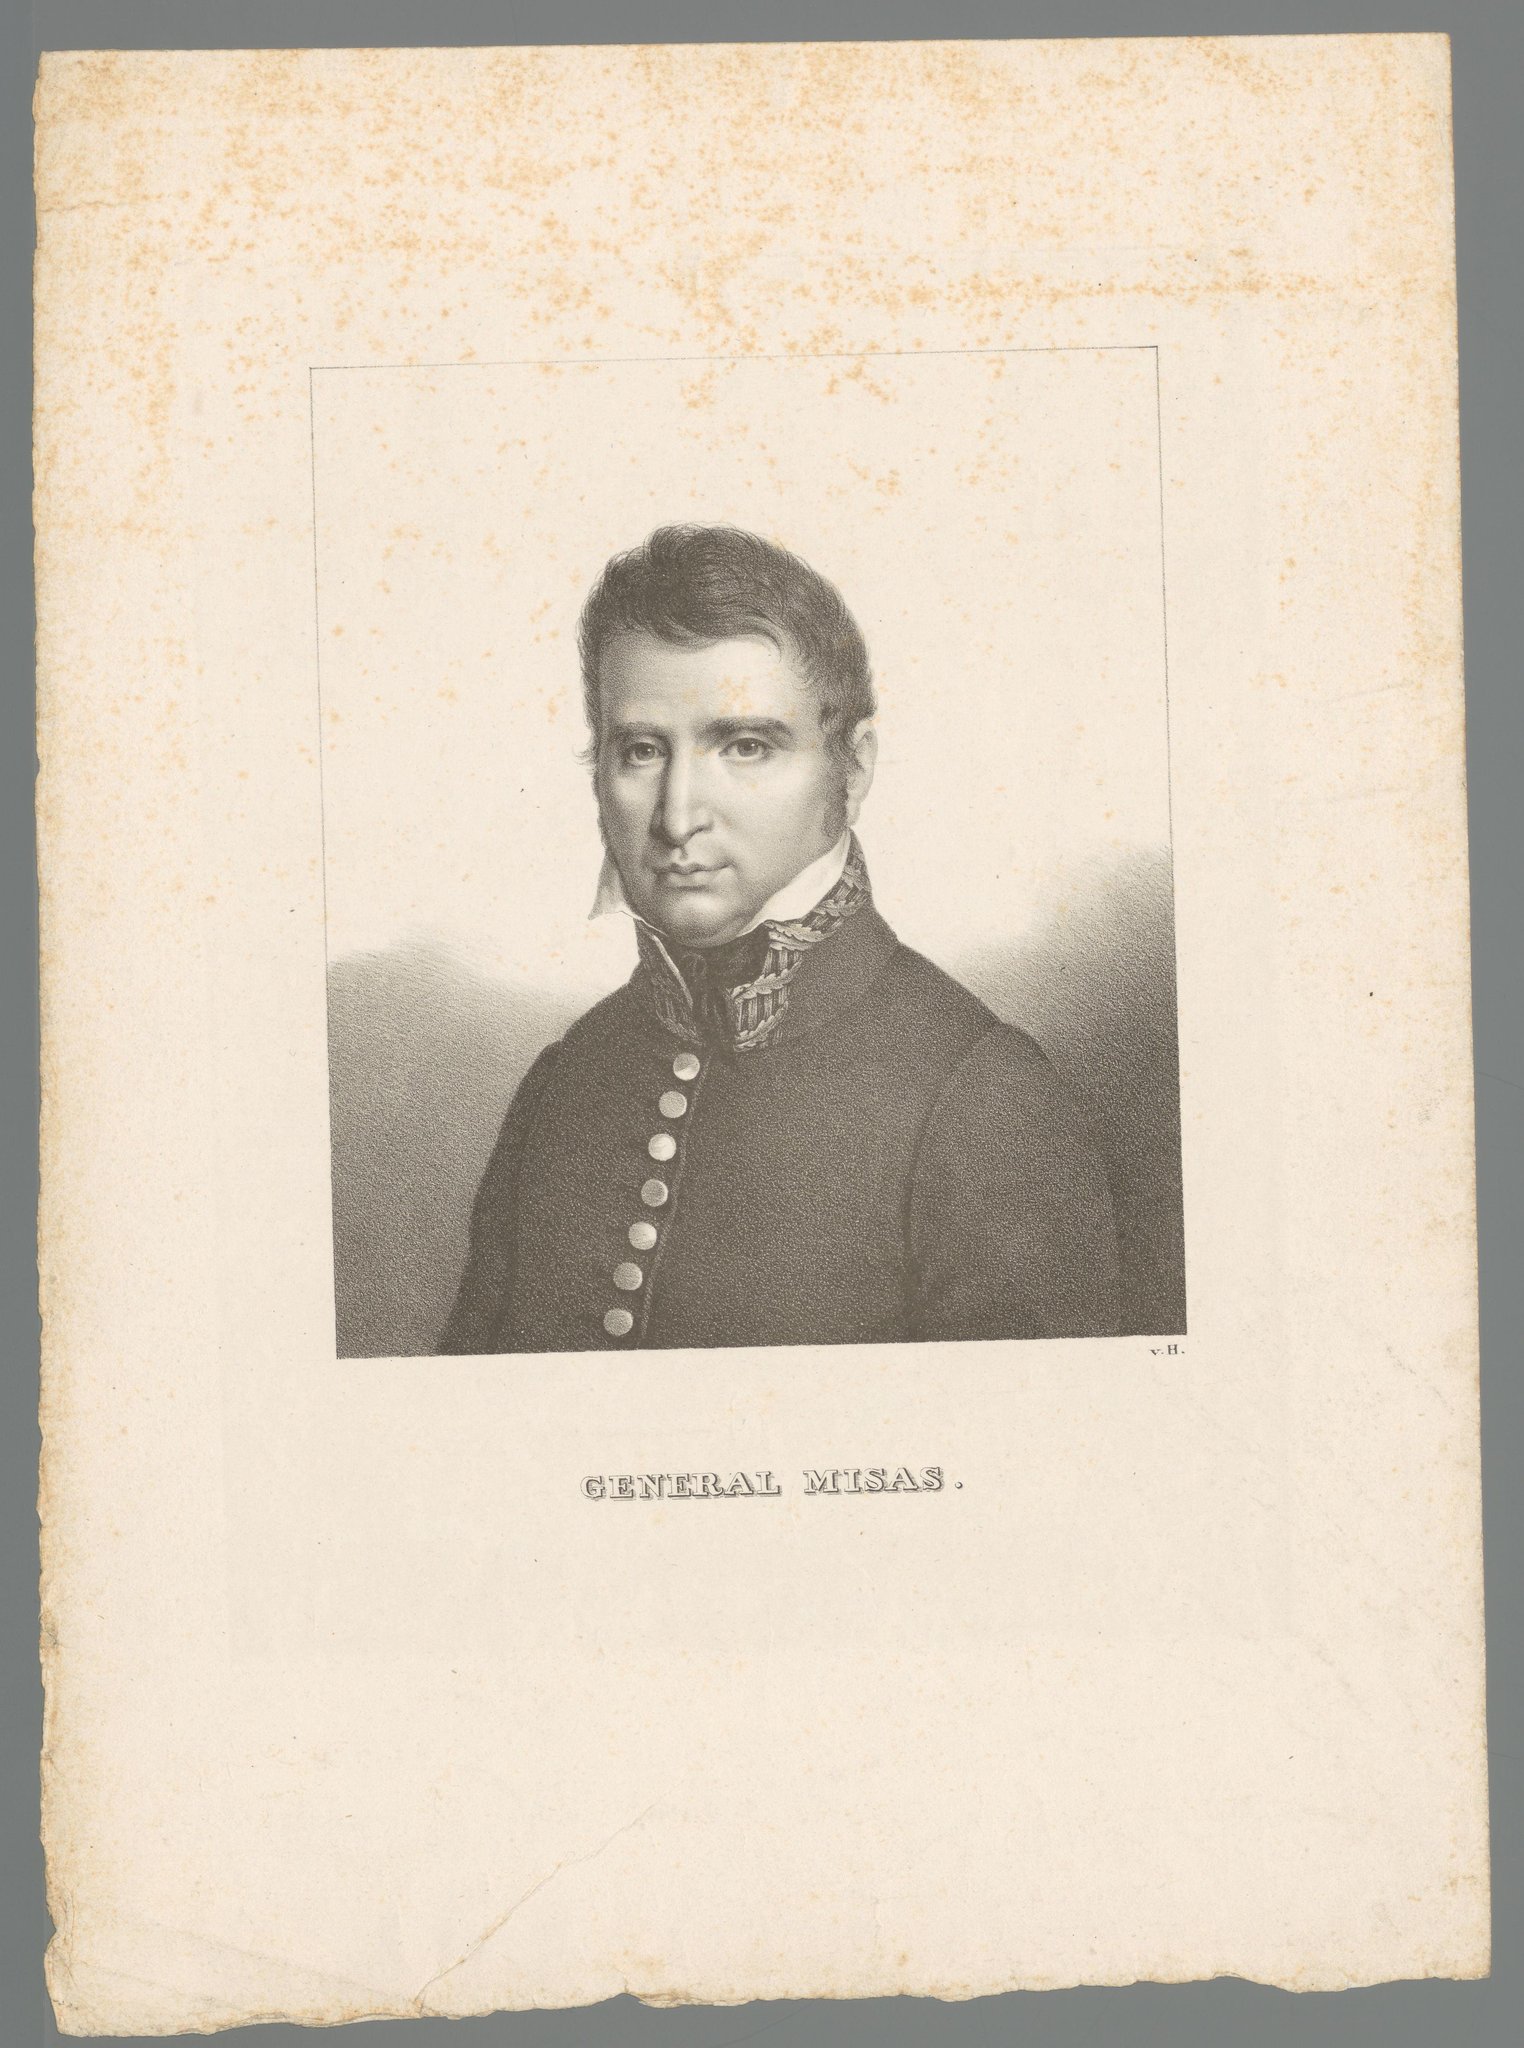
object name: print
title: Portret van Tomàs Costa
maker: f.b. van hove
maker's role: print maker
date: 1820-1860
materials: paper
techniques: lithograph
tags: adult man, historical persons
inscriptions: collector's mark: Lugt 2228